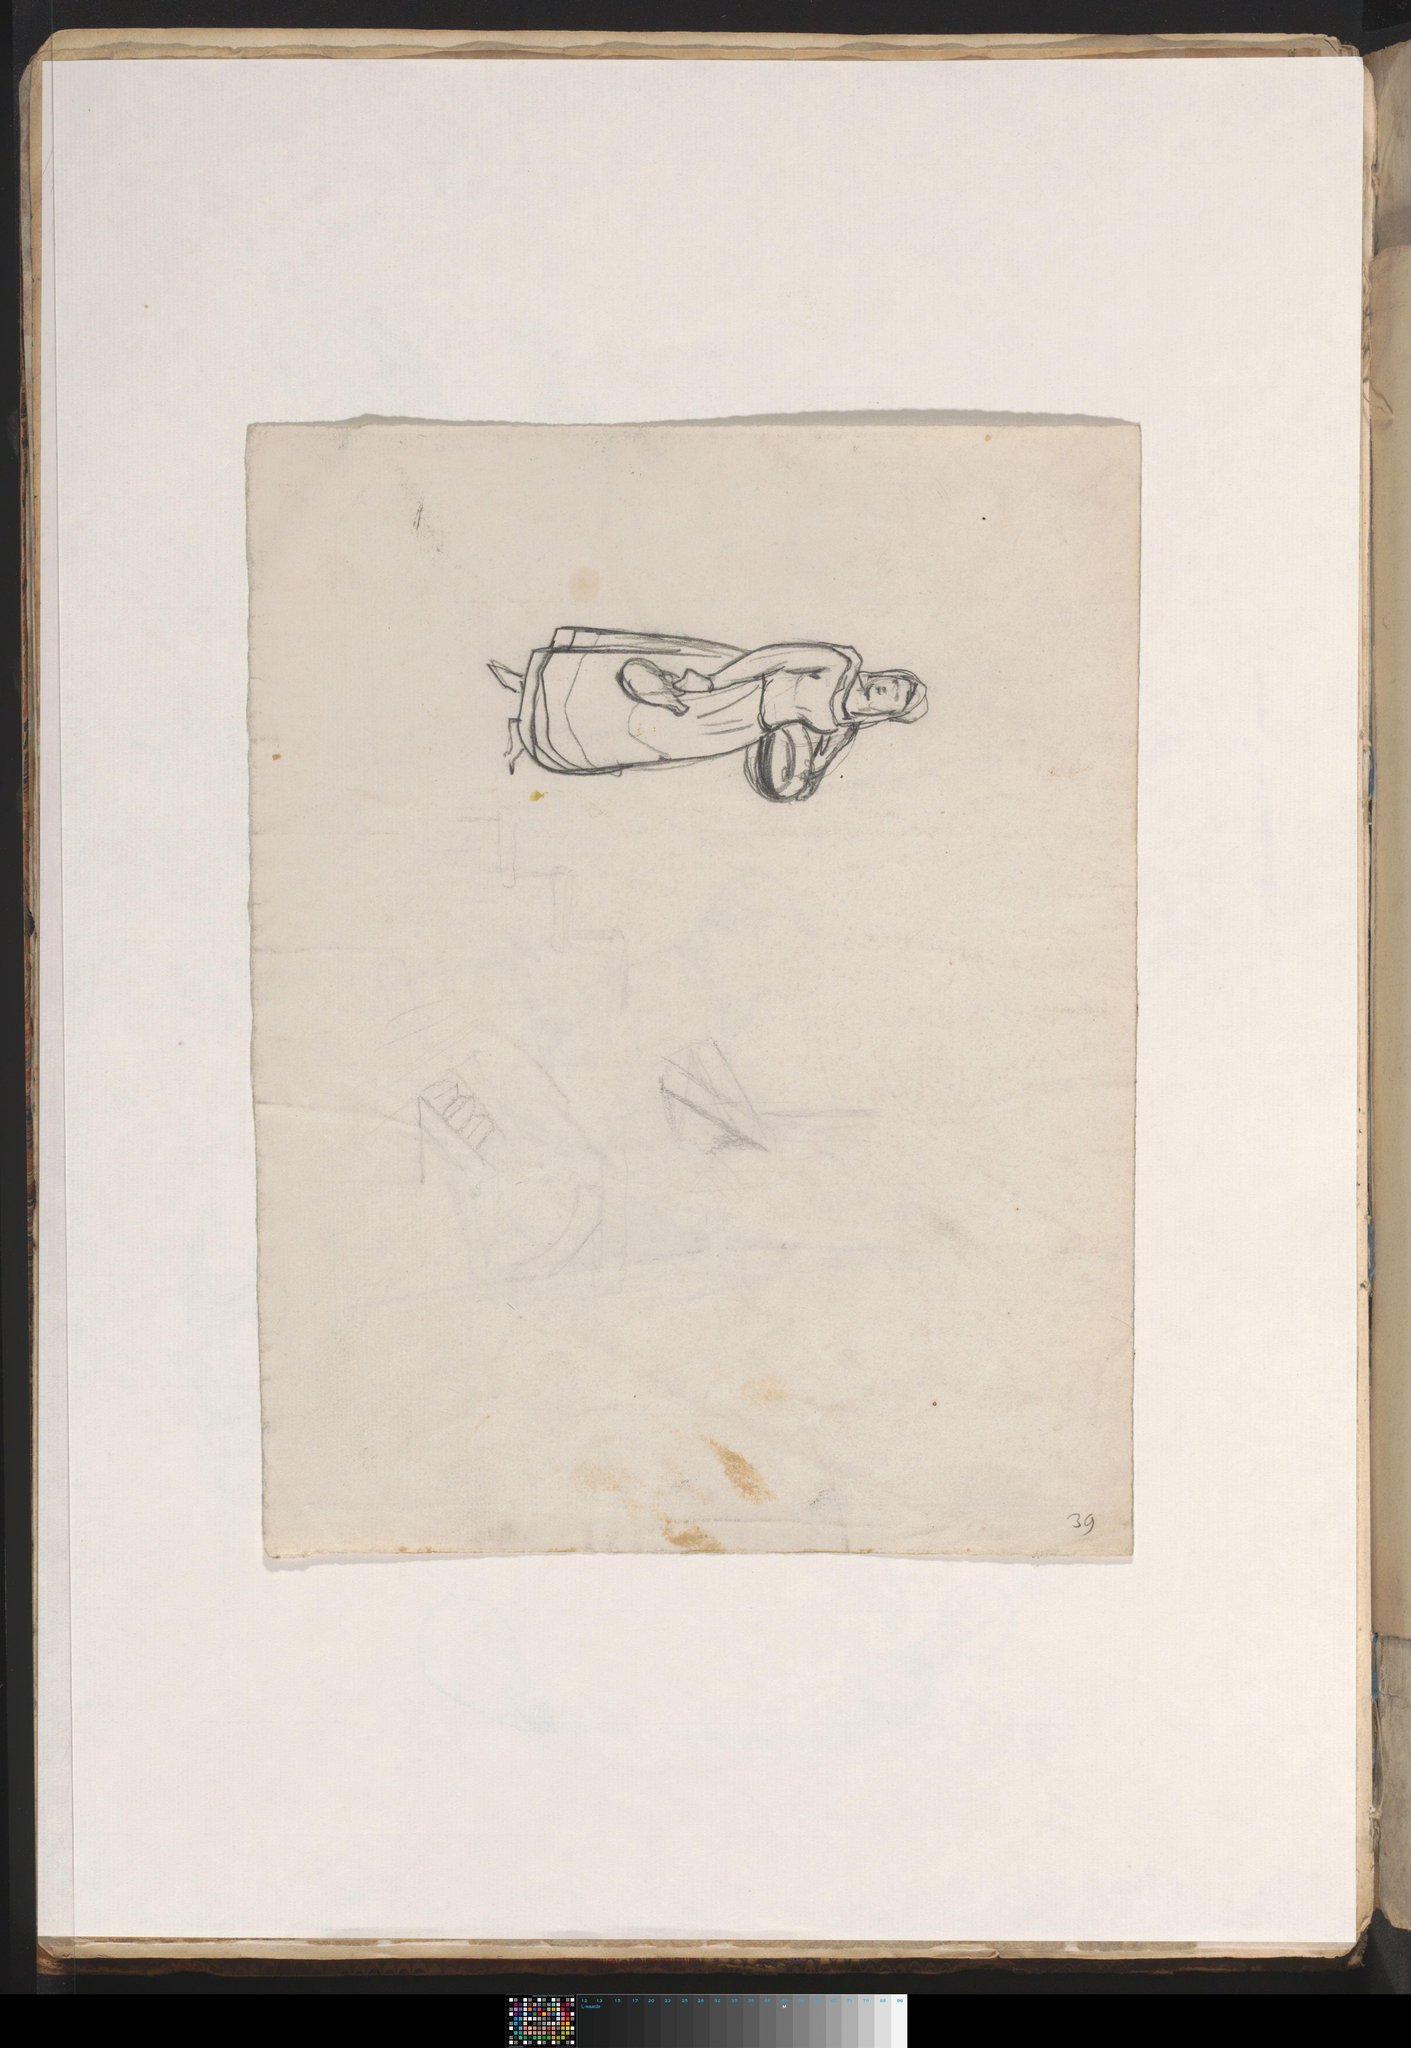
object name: sketchbook leaf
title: Vrouw met een schaal en kan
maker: johannes huybertus van hove bzn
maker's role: print maker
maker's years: 1827-1881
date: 1837-1881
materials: paper, pencil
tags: standing figure, staircase, container of ceramics: jar, jug, pot, vase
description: Tevens studies van een trap. Blad 39 verso, los blad in een schetsboek met 33 bladen en 10 losse tekeningen.